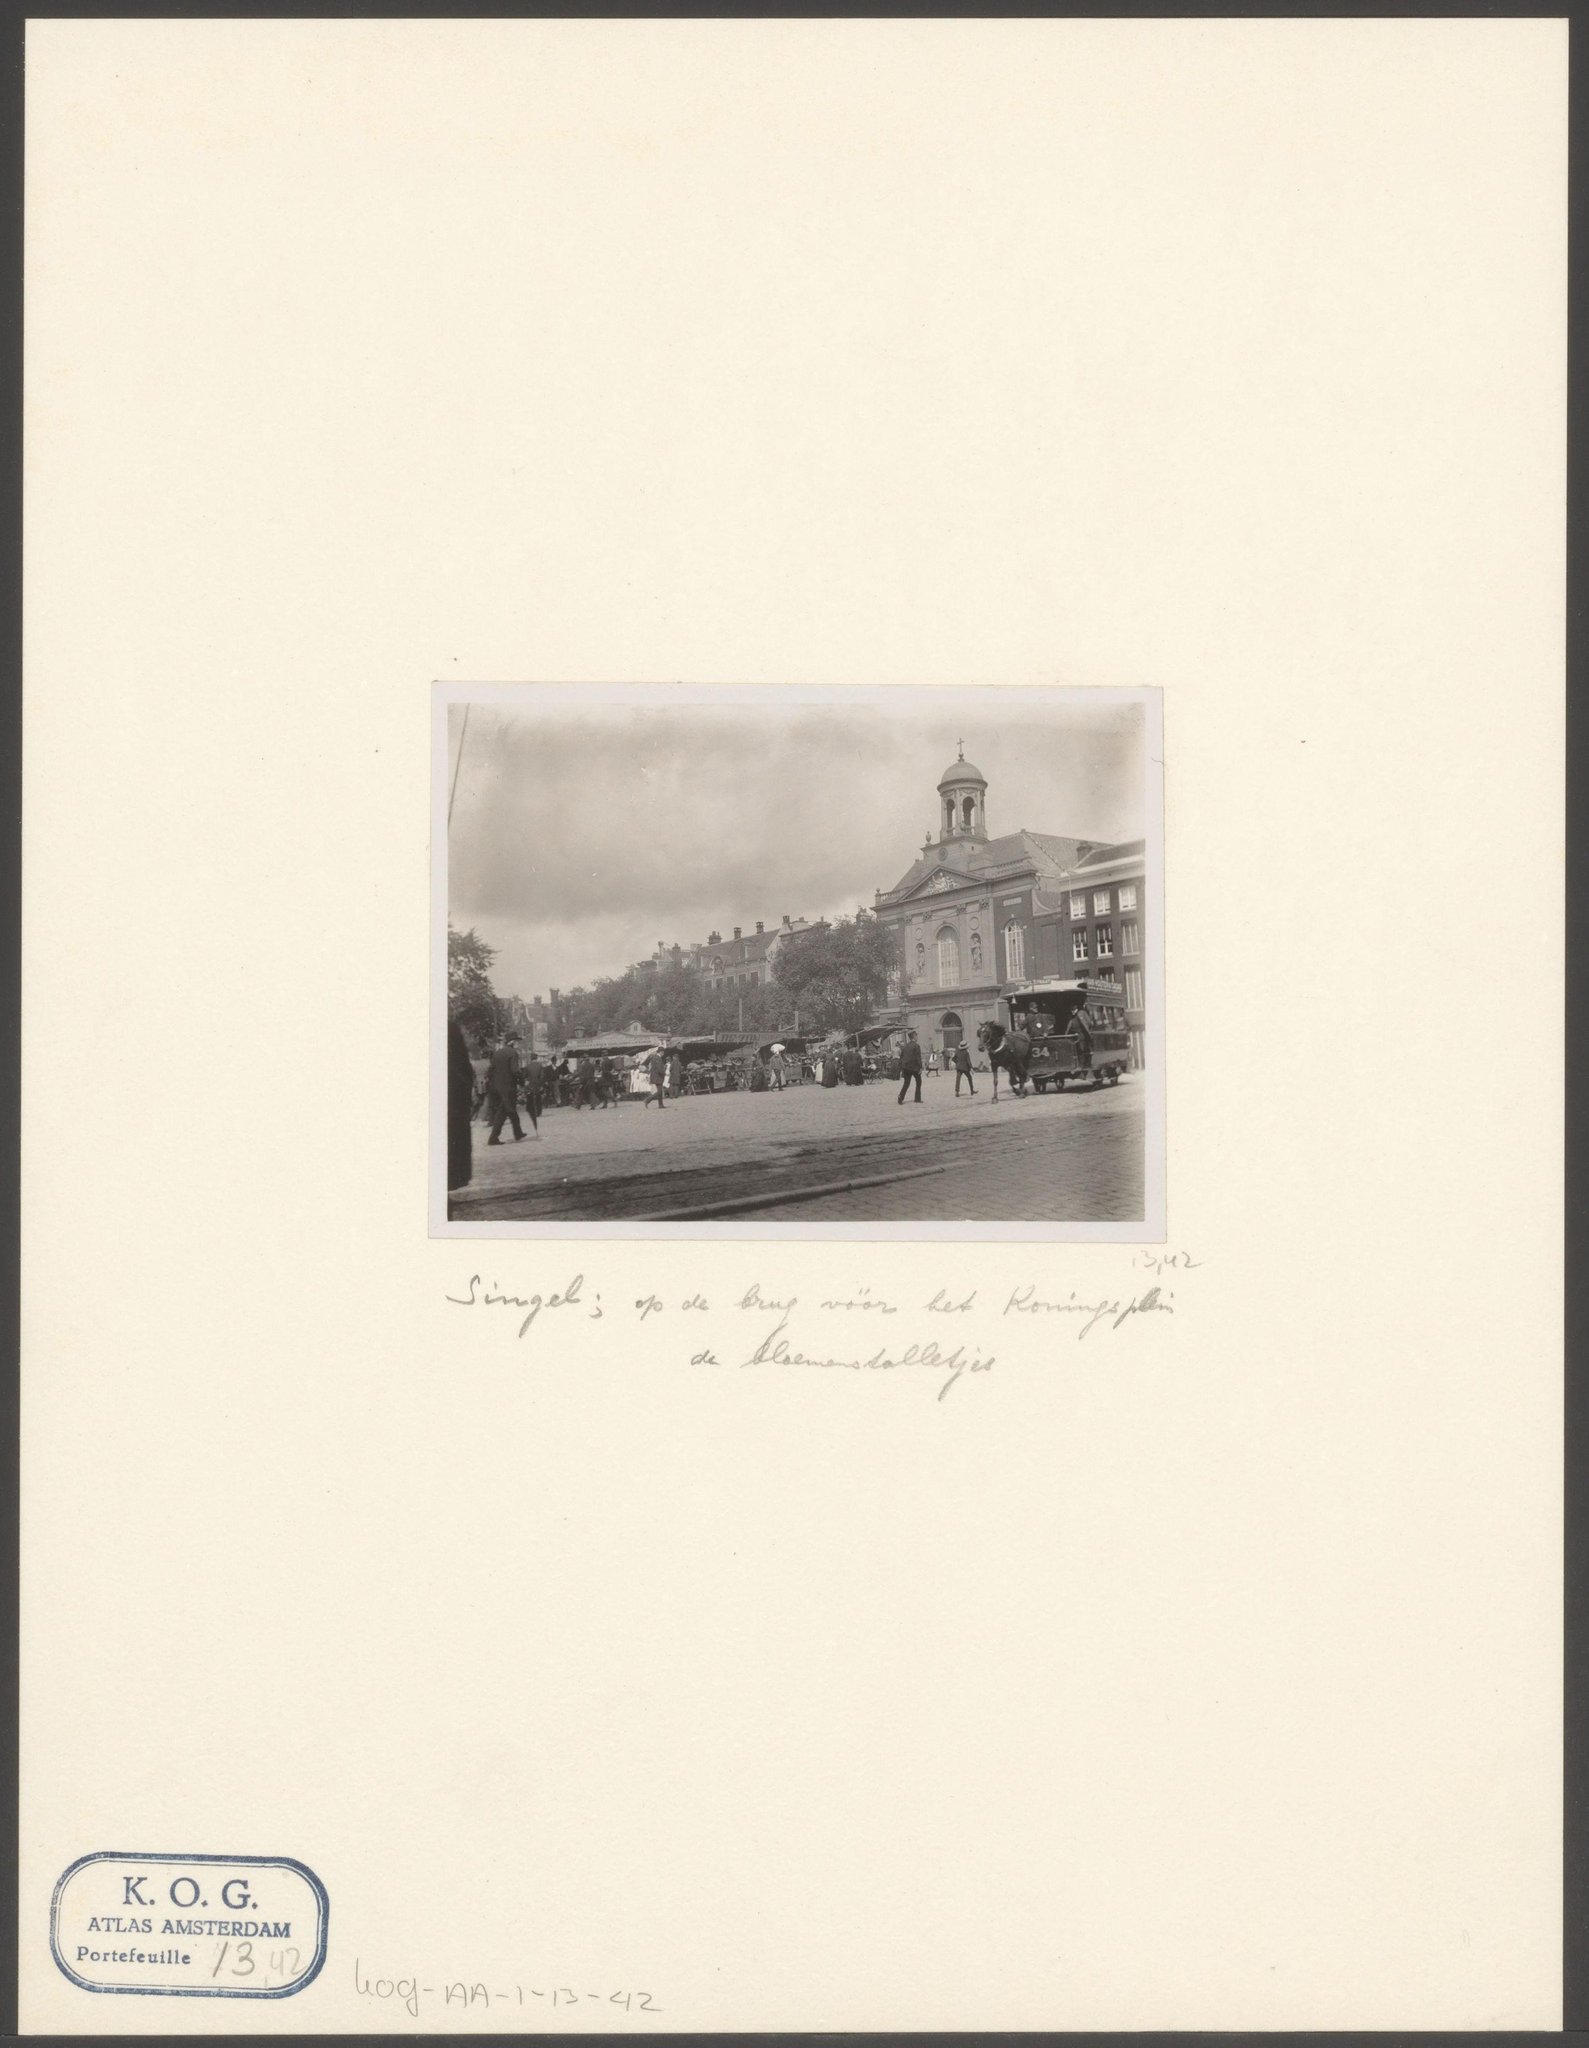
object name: photograph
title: Gezicht op het Singel op de brug voor het Koningsplein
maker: Anonymous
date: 1880-1950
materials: paper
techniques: gelatin silver print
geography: amsterdam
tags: square, place, circus, etc., city-view in general; 'veduta', market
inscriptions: collector's mark: ‘13,42’ Lugt 1641b, inscription: ‘Singel; op de brug vóór het Koningsplein / de bloemenstalletjes’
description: Onderwerpsrubriek binnen de Atlas Amsterdam: Oude Schans, Schoutensteeg, Singel (Korte), Singel.